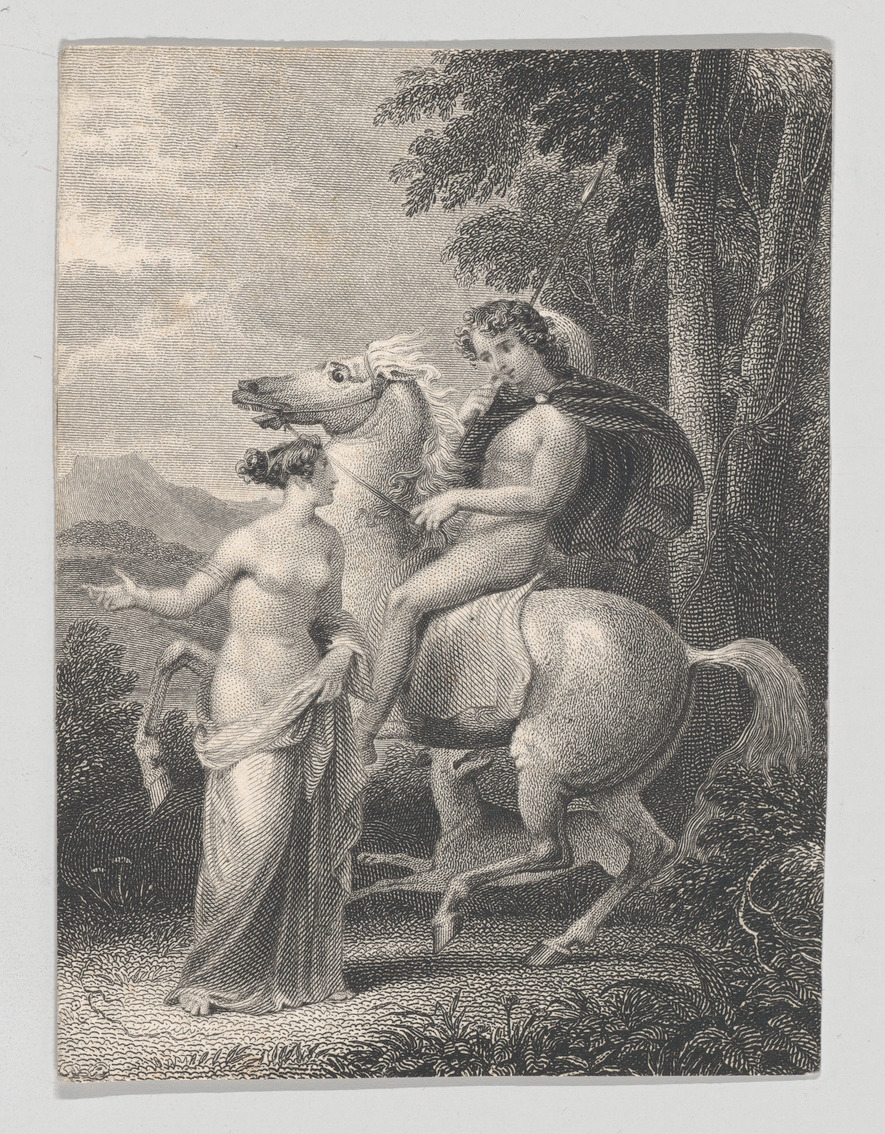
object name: print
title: Venus and Adonis (Shakespeare, Poems, Verse 3, line 13)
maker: charles rolls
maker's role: engraver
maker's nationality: british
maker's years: 1799-1885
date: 1825-1840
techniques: engraving, etching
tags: adonis,venus,horses